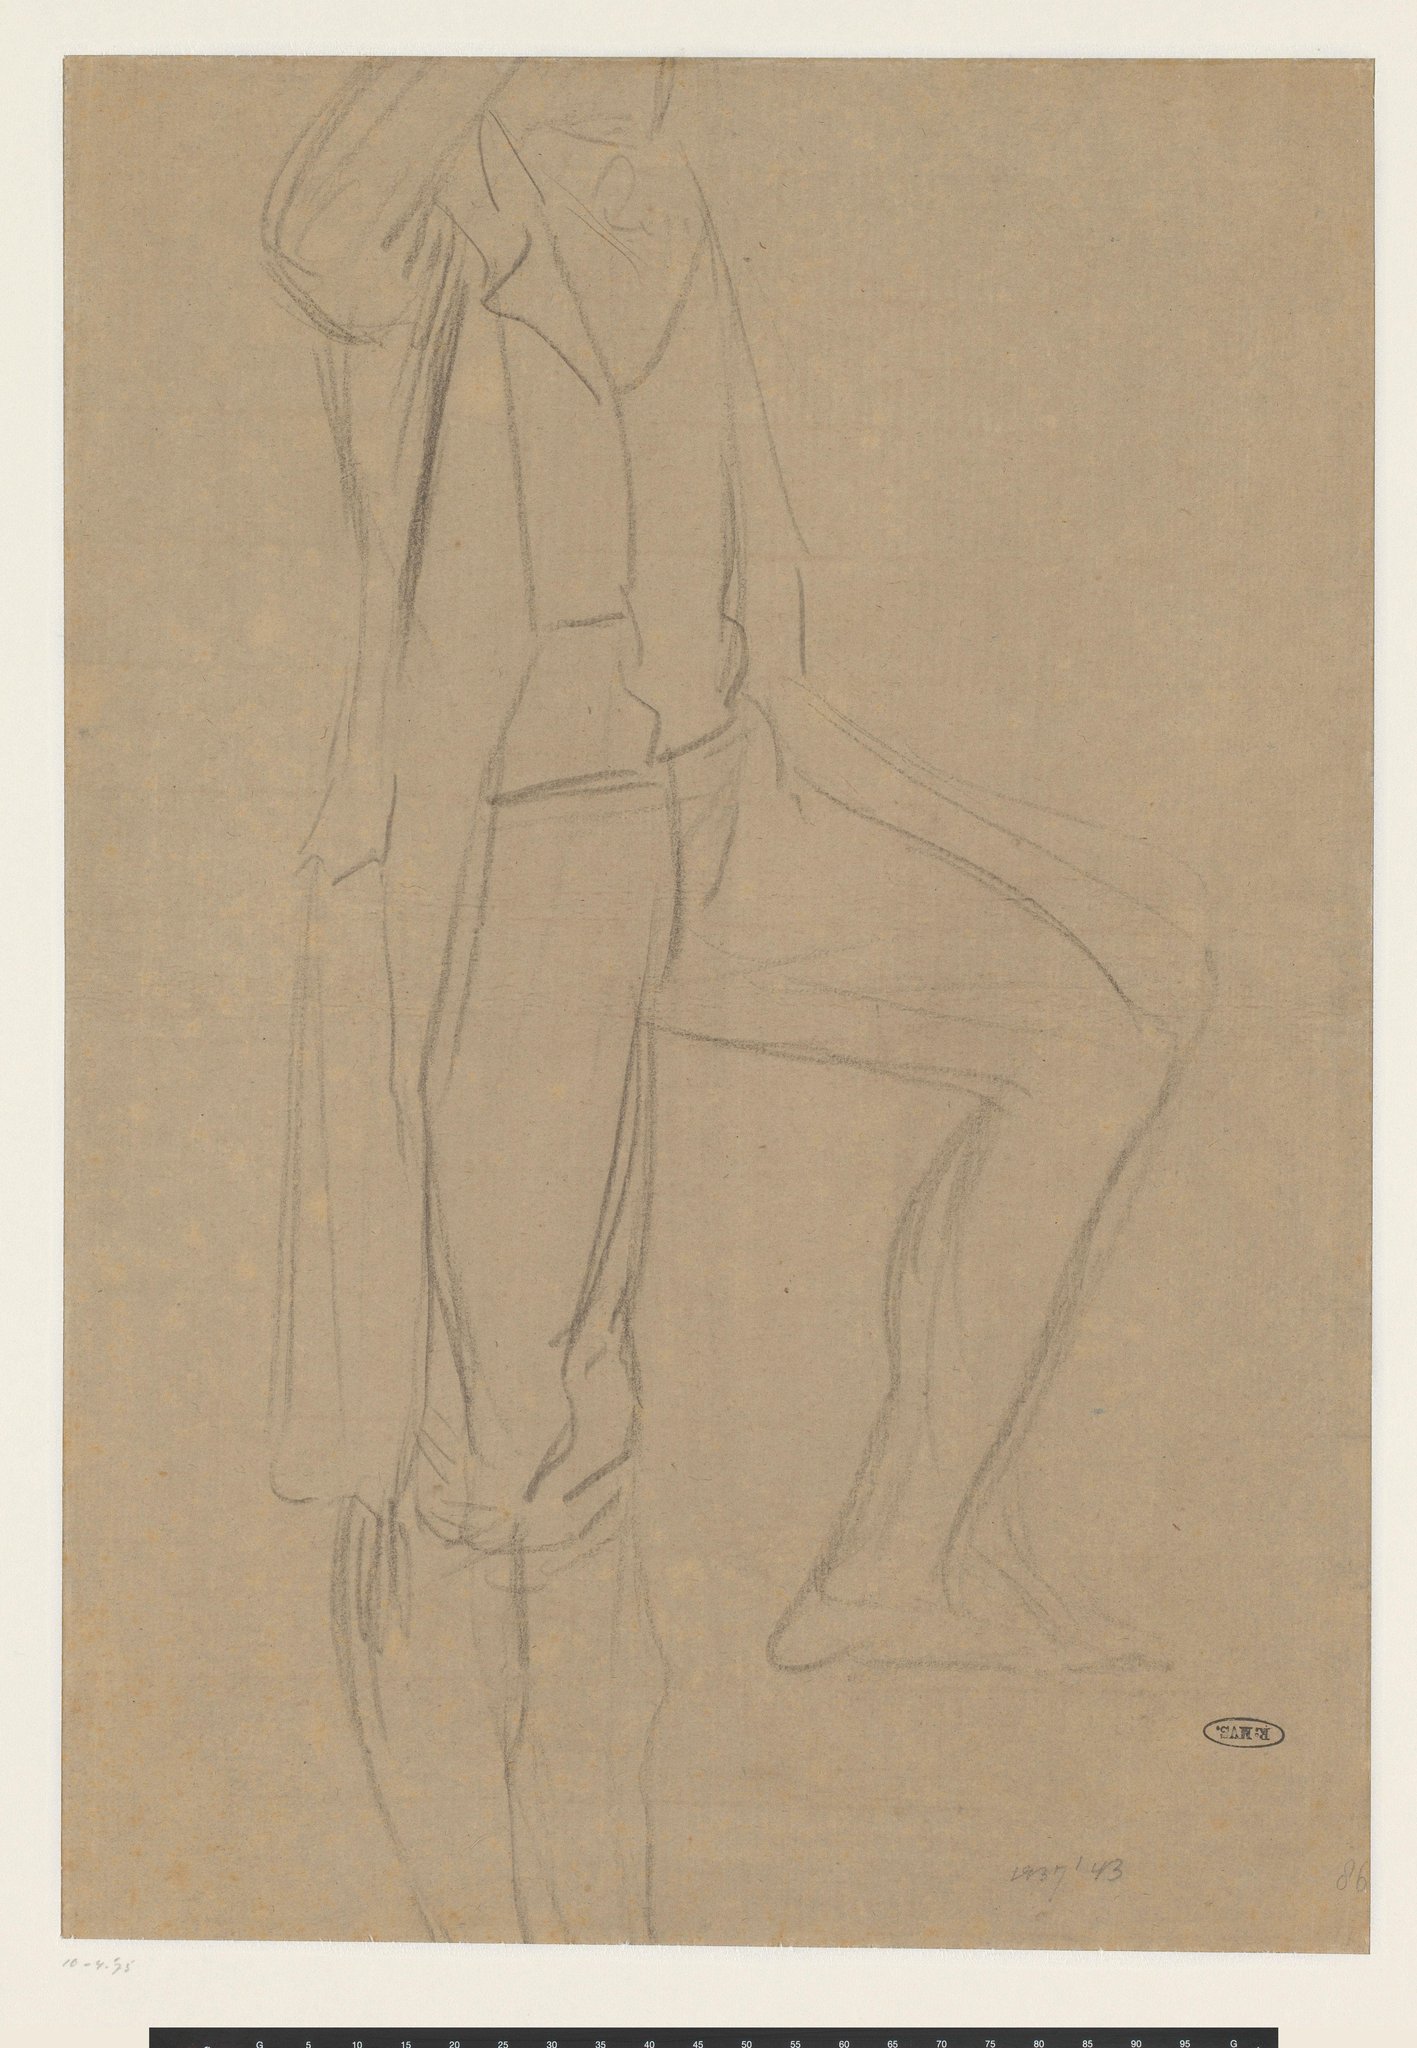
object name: drawing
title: Staande man met geheven linkerbeen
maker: taco scheltema (i)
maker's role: draughtsman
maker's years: 1760-1837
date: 1770-1837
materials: paper, pencil